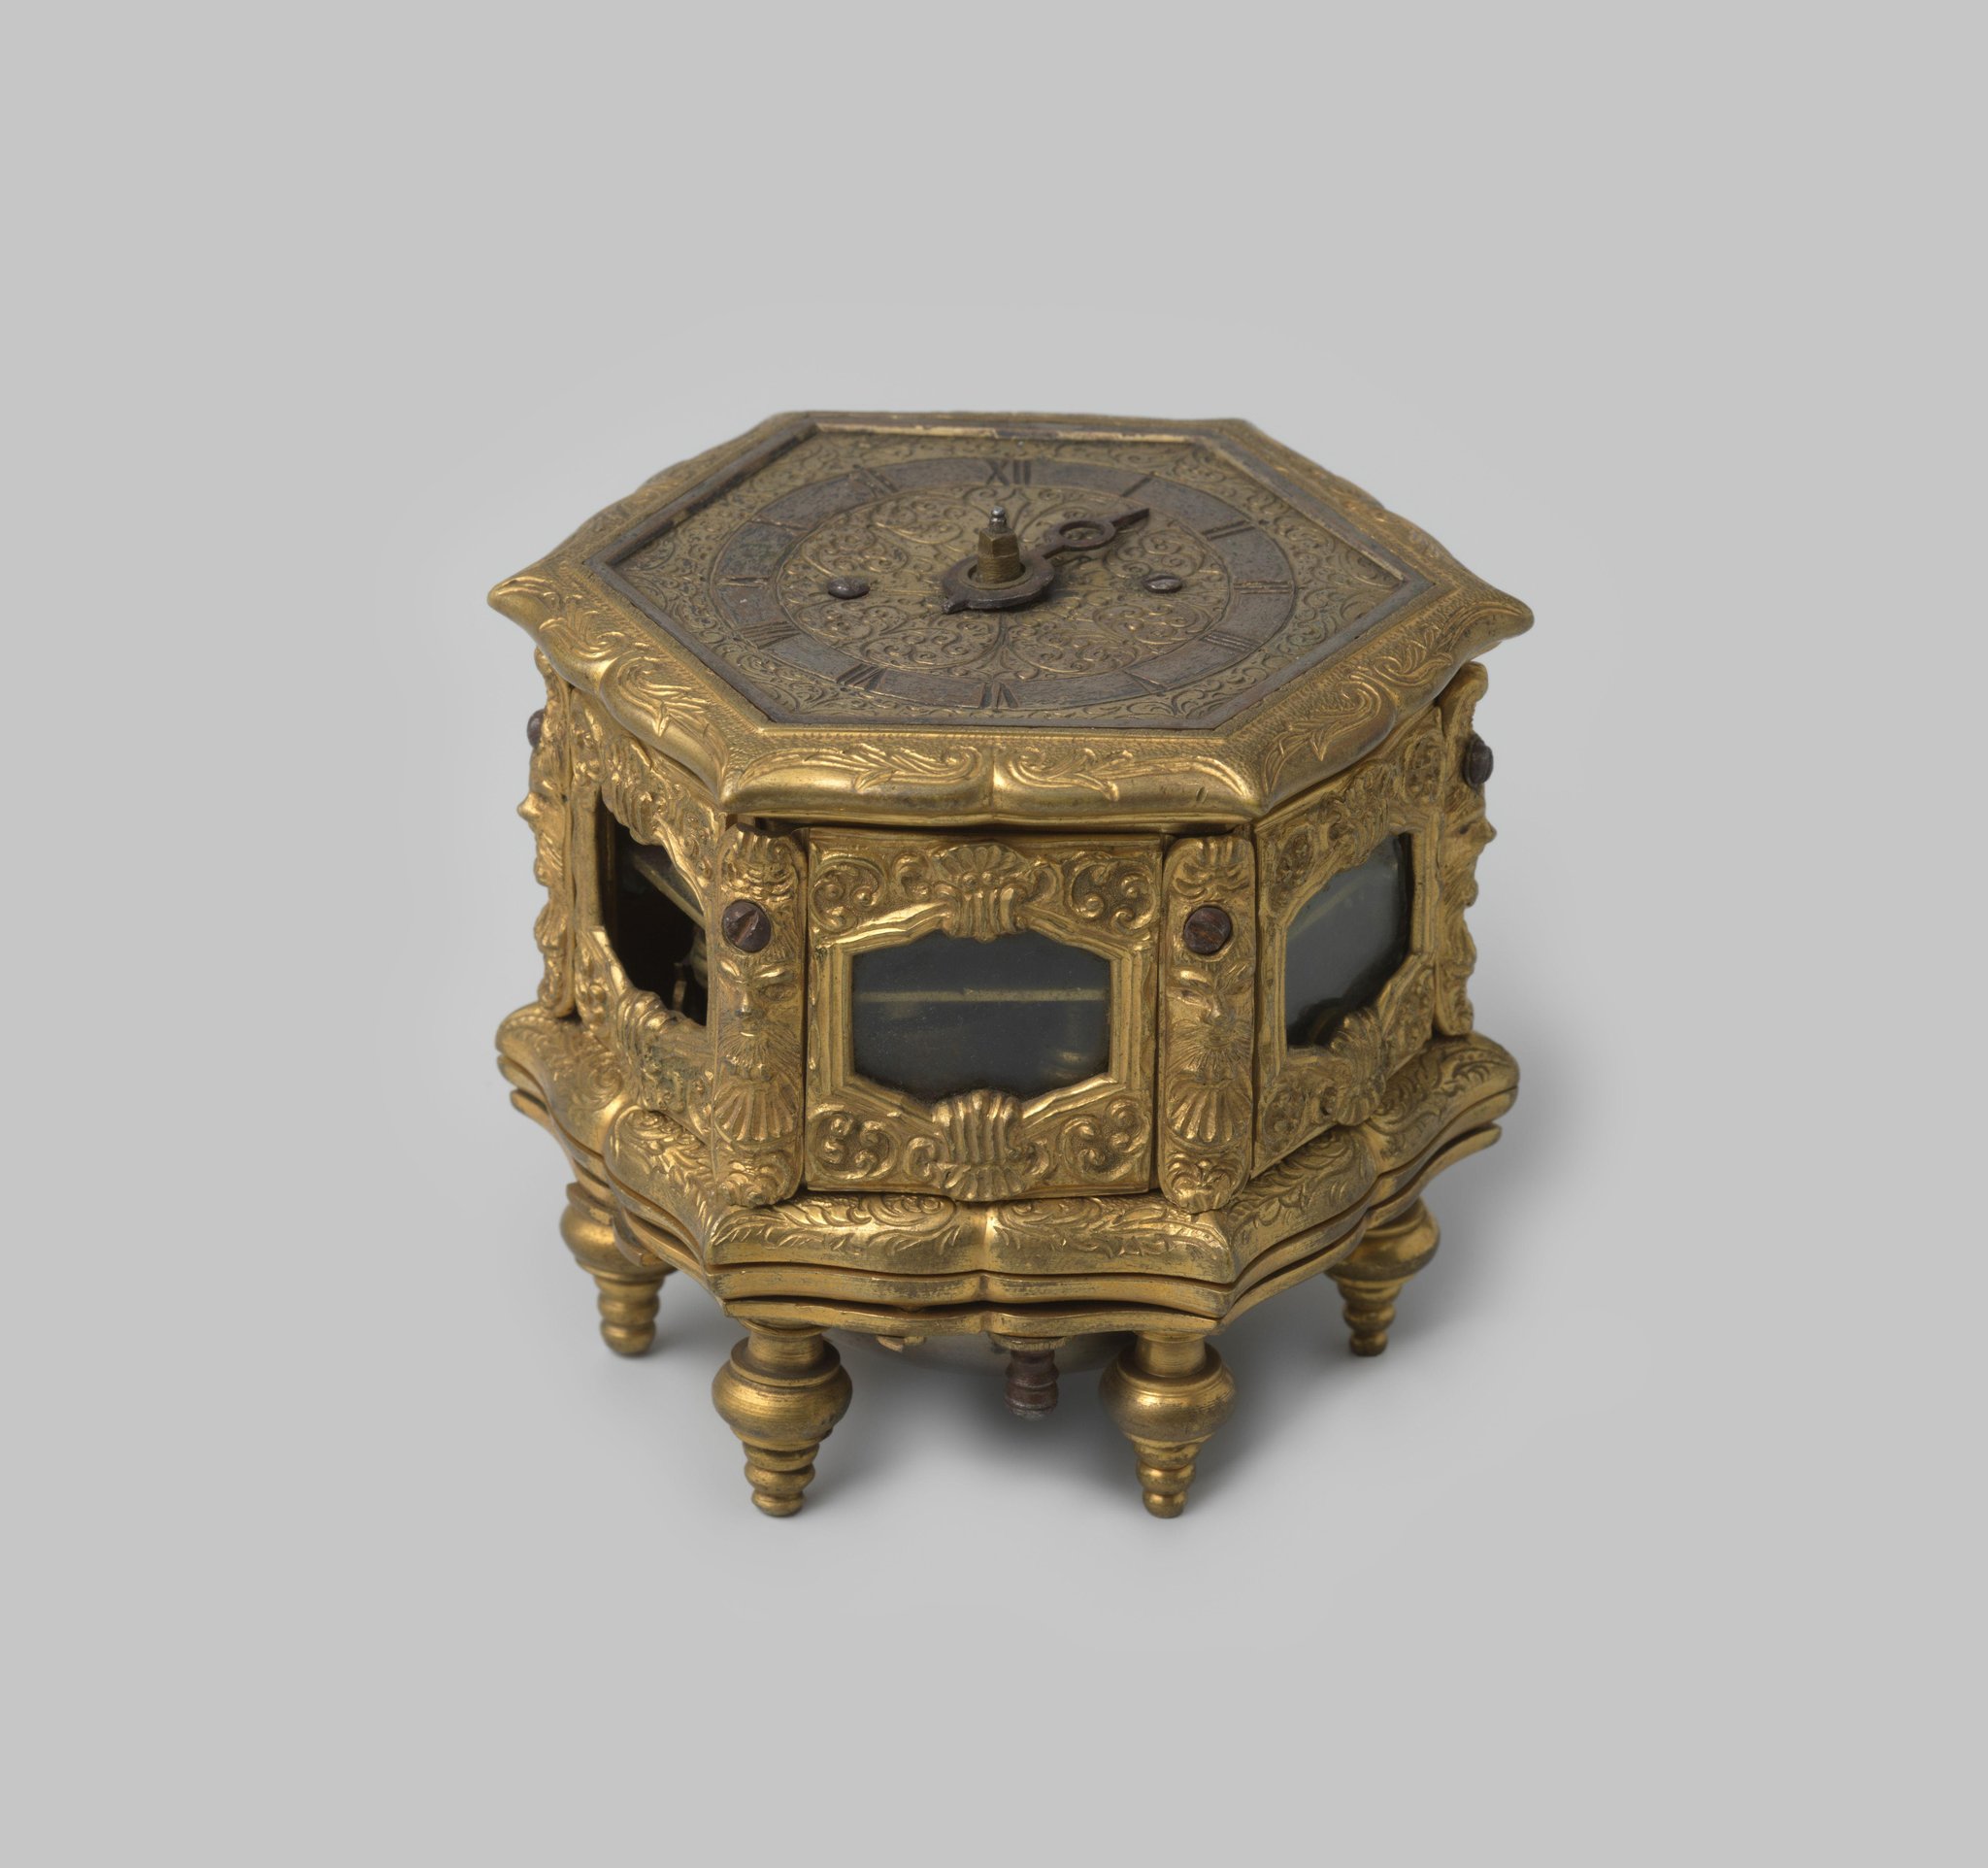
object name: table clock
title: Tafelhorloge versierd met schelpvormen en maskers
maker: franciscus bielauschek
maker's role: clockmaker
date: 1700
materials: copper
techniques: engraving, gilding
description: Zeskantig tafelhorloge van verguld koper op zes poten. Versierd met schelpvormen en maskers. De wijzerplaat is gegraveerd. Vermoedelijk een kopie.